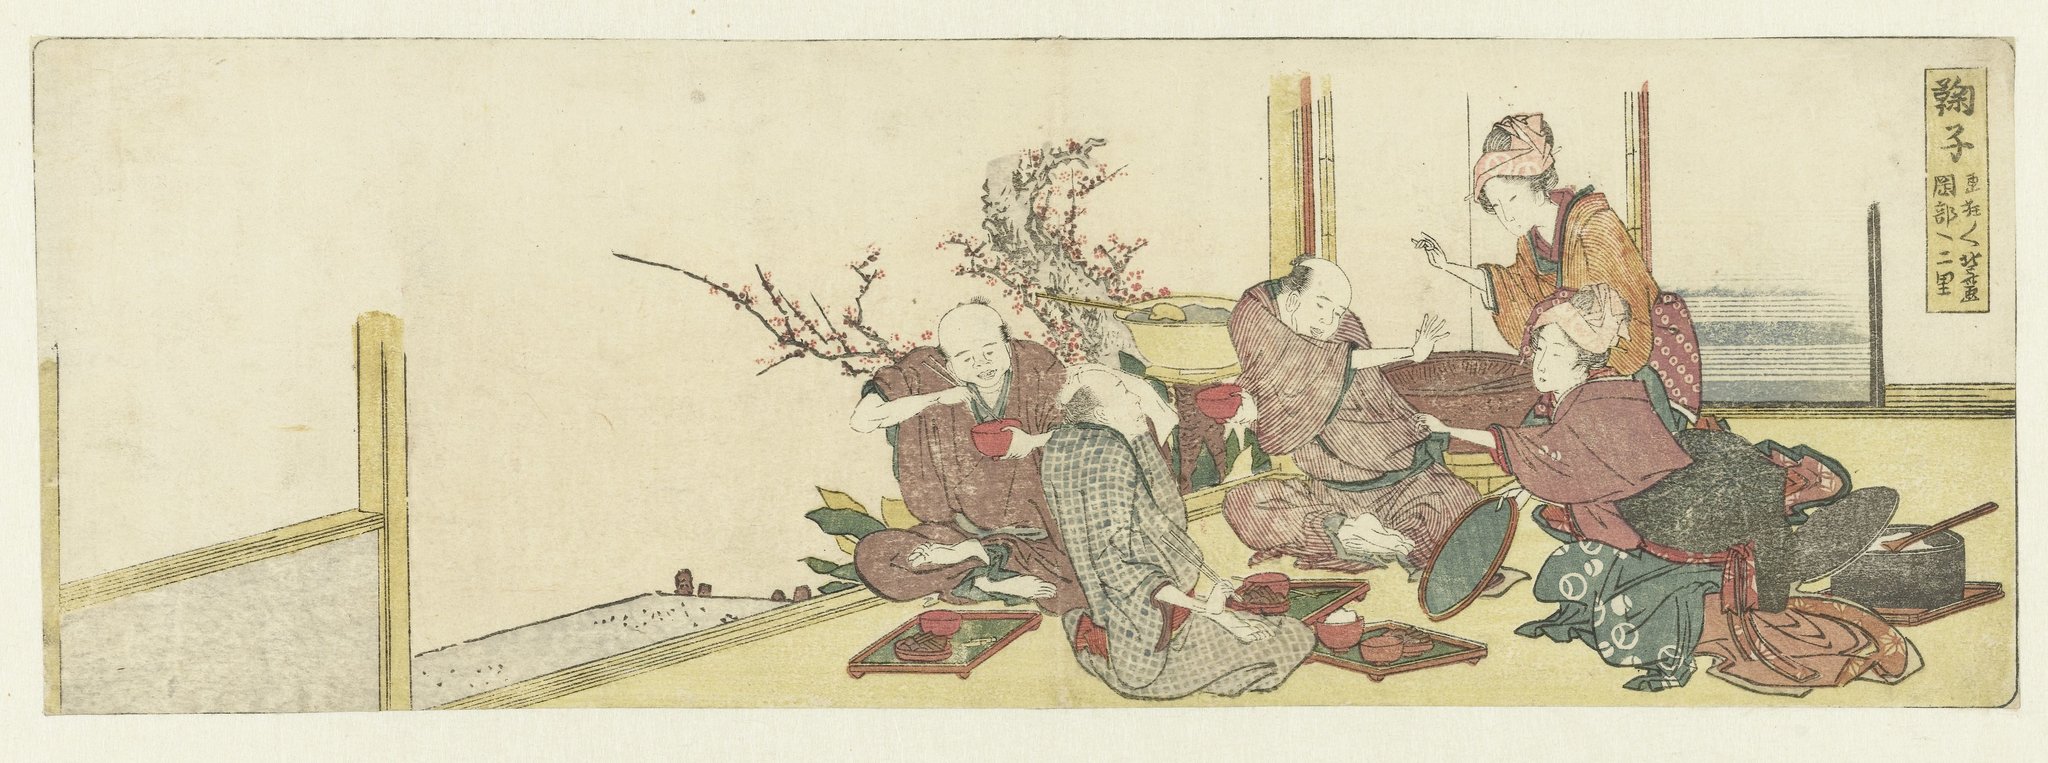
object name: surimono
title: Mariko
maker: katsushika hokusai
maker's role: draughtsman, print maker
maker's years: 1760-1849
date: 1804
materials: paper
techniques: blind stamped, woodcut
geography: japan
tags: nutrition, nourishment, inn, coffee-house, public house, etc.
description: Een surimono is een luxe uitgevoerde prent waarop beeld met één of meerdere gedichten gecombineerd is. Bij het drukken van een surimono werd vaak gebruik gemaakt van dikker papier, blinddruk en metaal pigmenten, zoals koper- en zilverpoeder. De prenten werden vaak in opdracht van dichters gemaakt en als exclusief geschenk aan vrienden en relaties gegeven. Bij het drukken van deze prent is het houtblok waar de gedichten op stonden weggelaten.